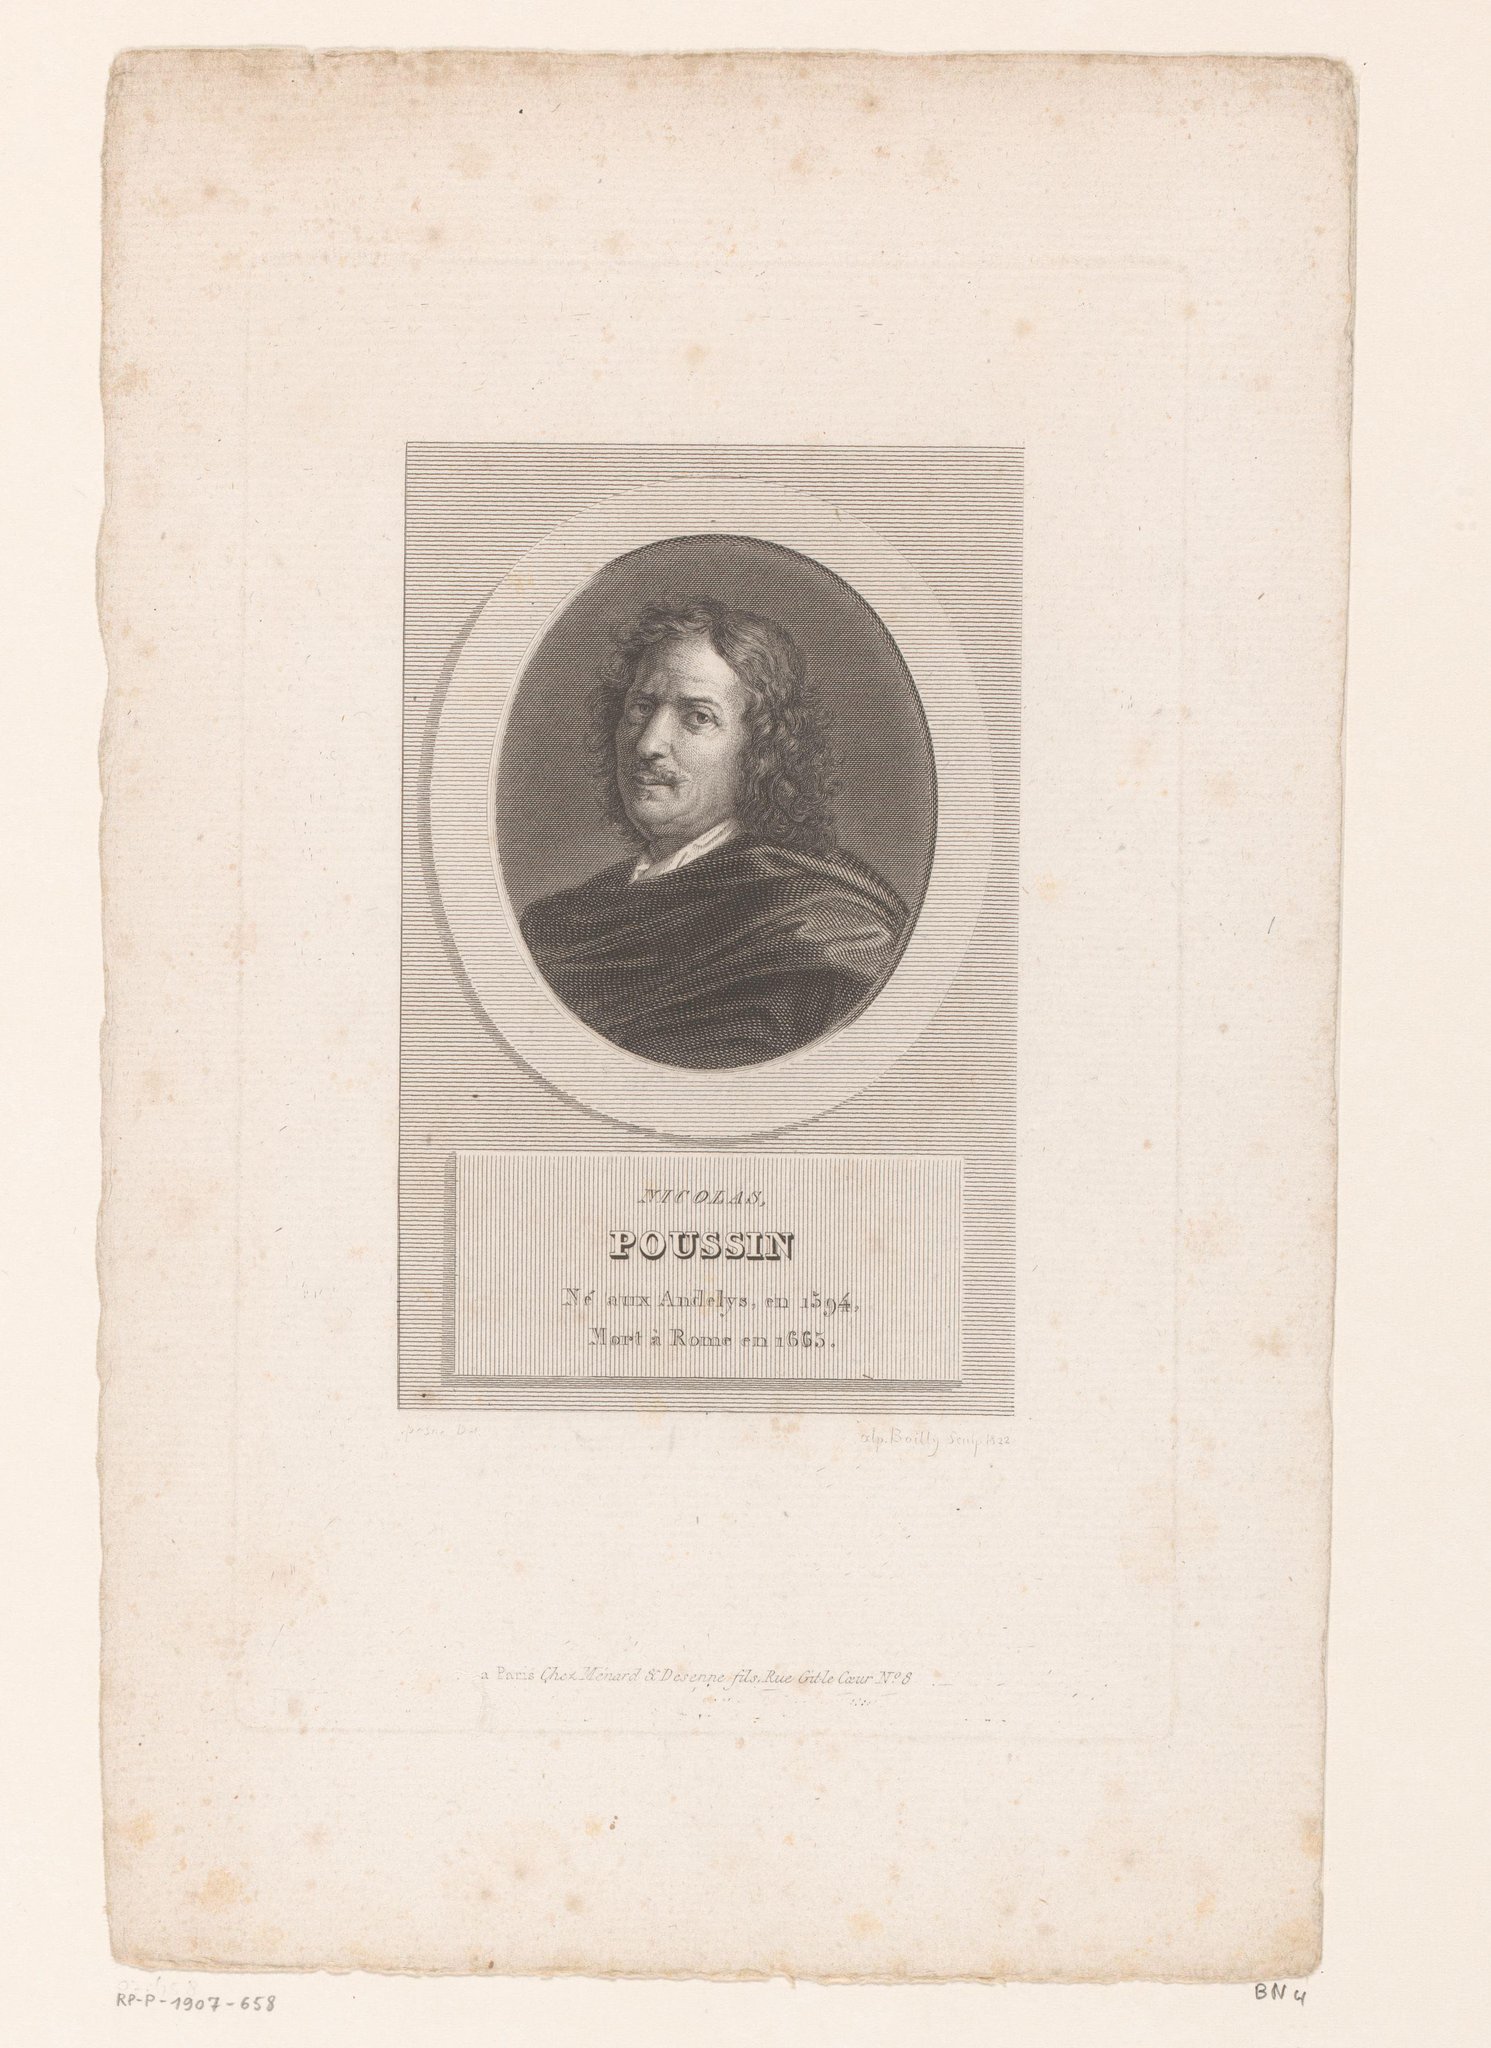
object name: print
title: Portret van Nicolas Poussin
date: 1822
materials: paper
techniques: engraving, etching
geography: france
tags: rome, painter, draughtsman, nicolas poussin, ornament ~ medallion, historical persons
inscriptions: collector's mark: Lugt 2228